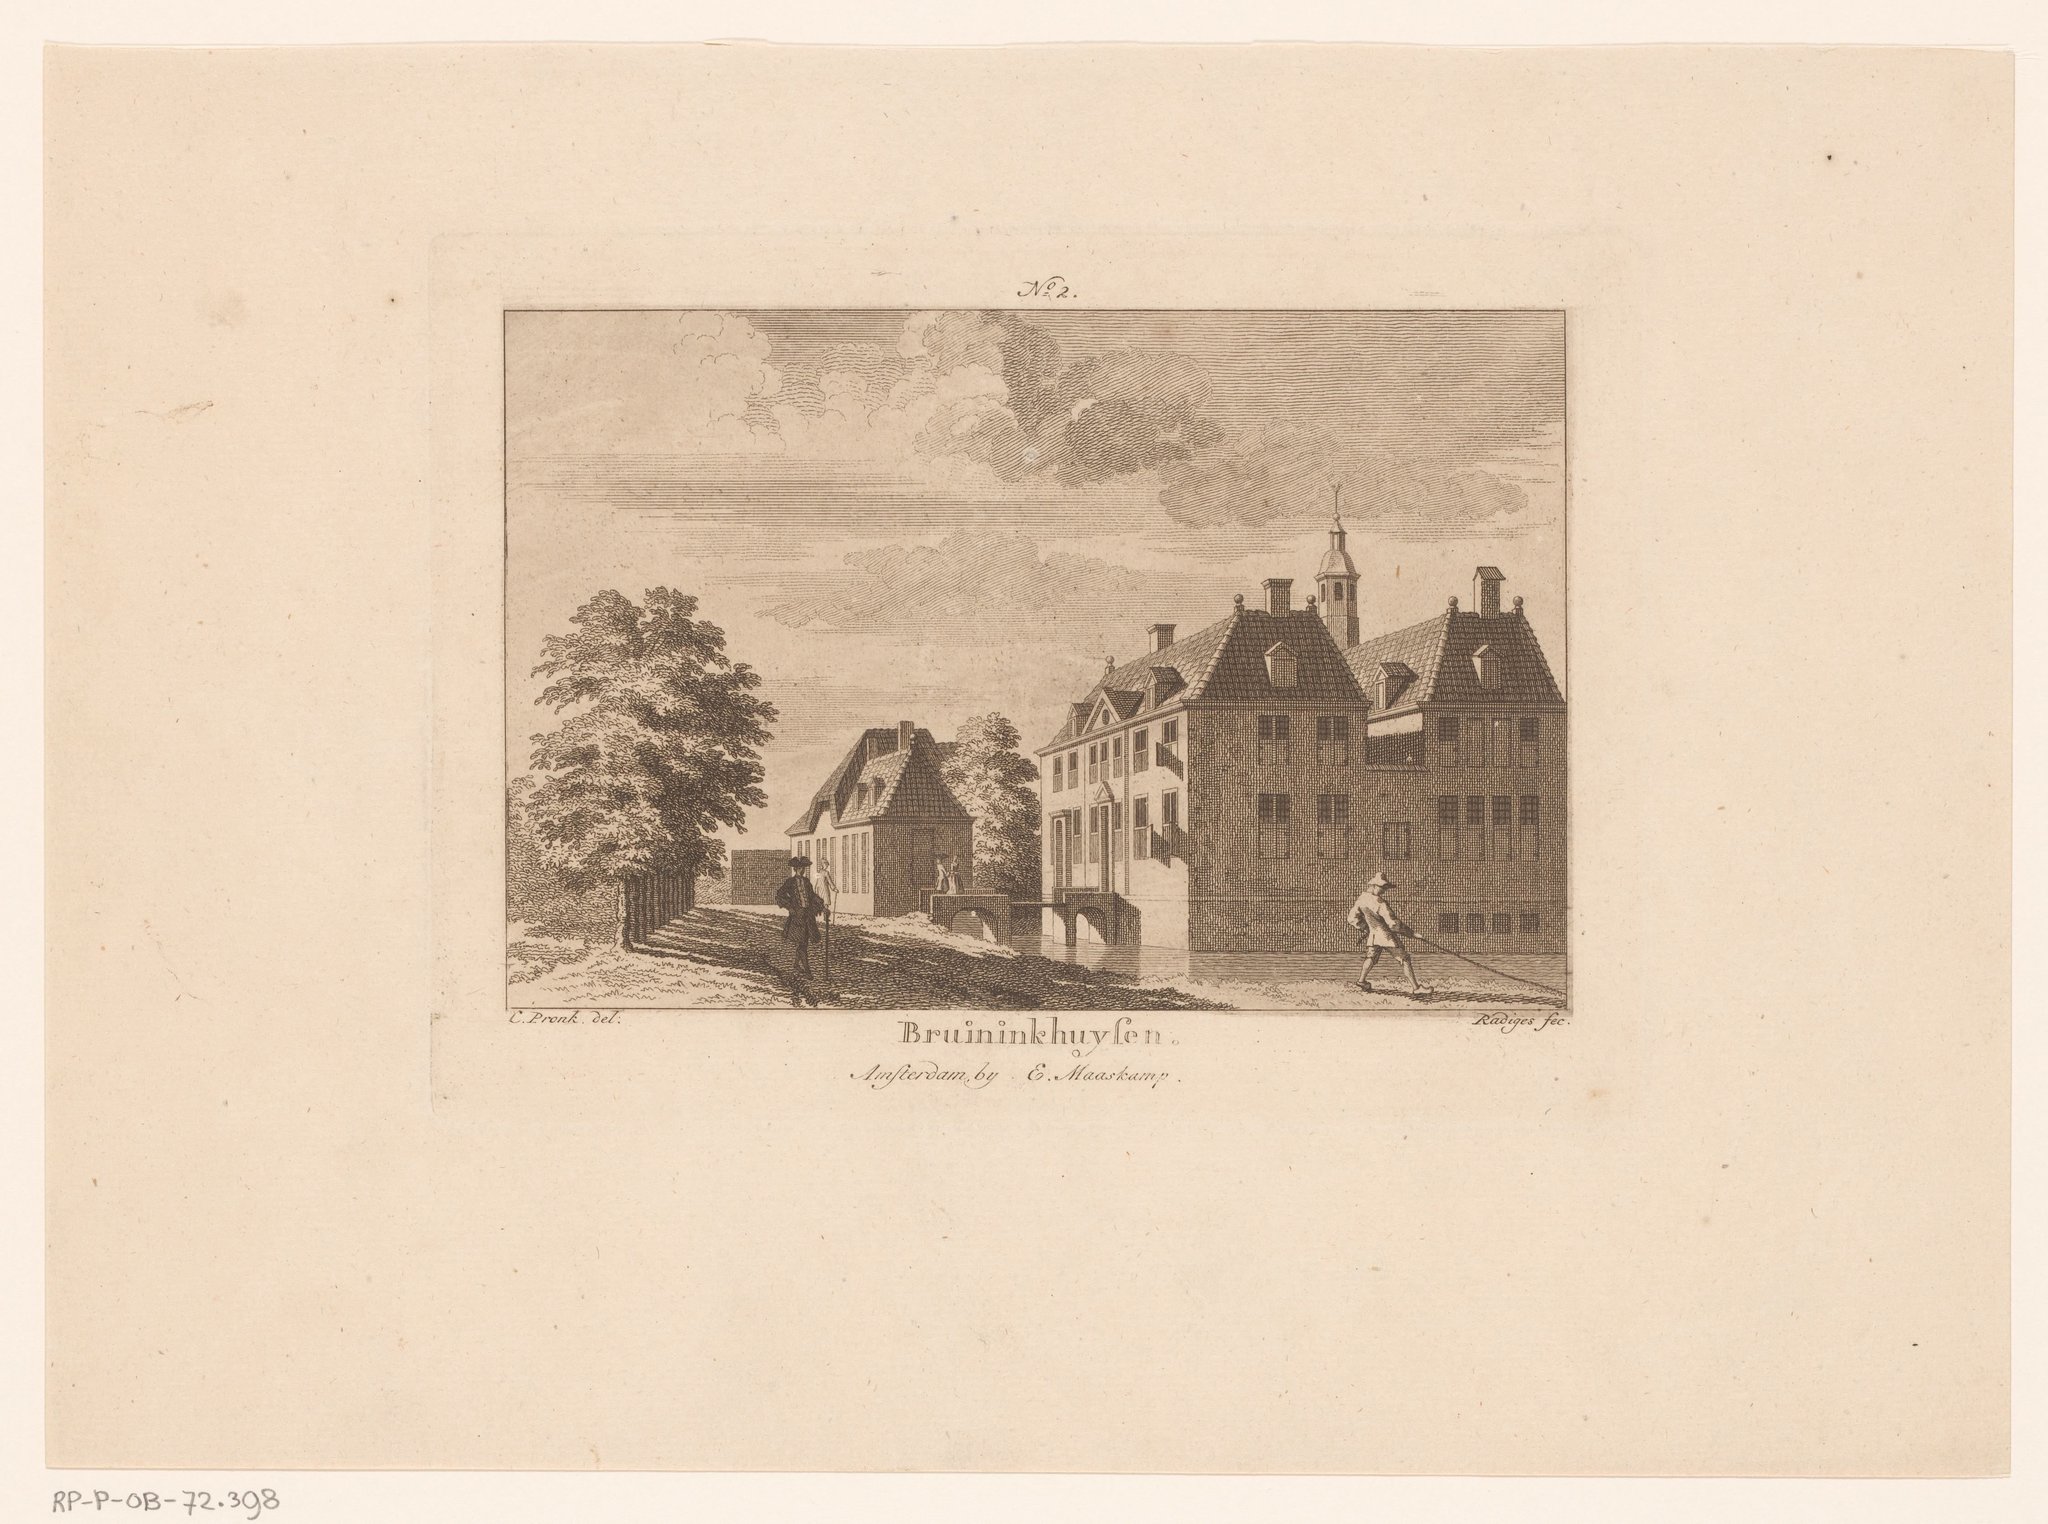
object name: print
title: Portret van Catharina II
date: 1768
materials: paper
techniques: engraving, etching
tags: catharina de grote, historical persons, emperor - bb - female ruler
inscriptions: collector's mark: Lugt 2166, collector's mark: Lugt 2760